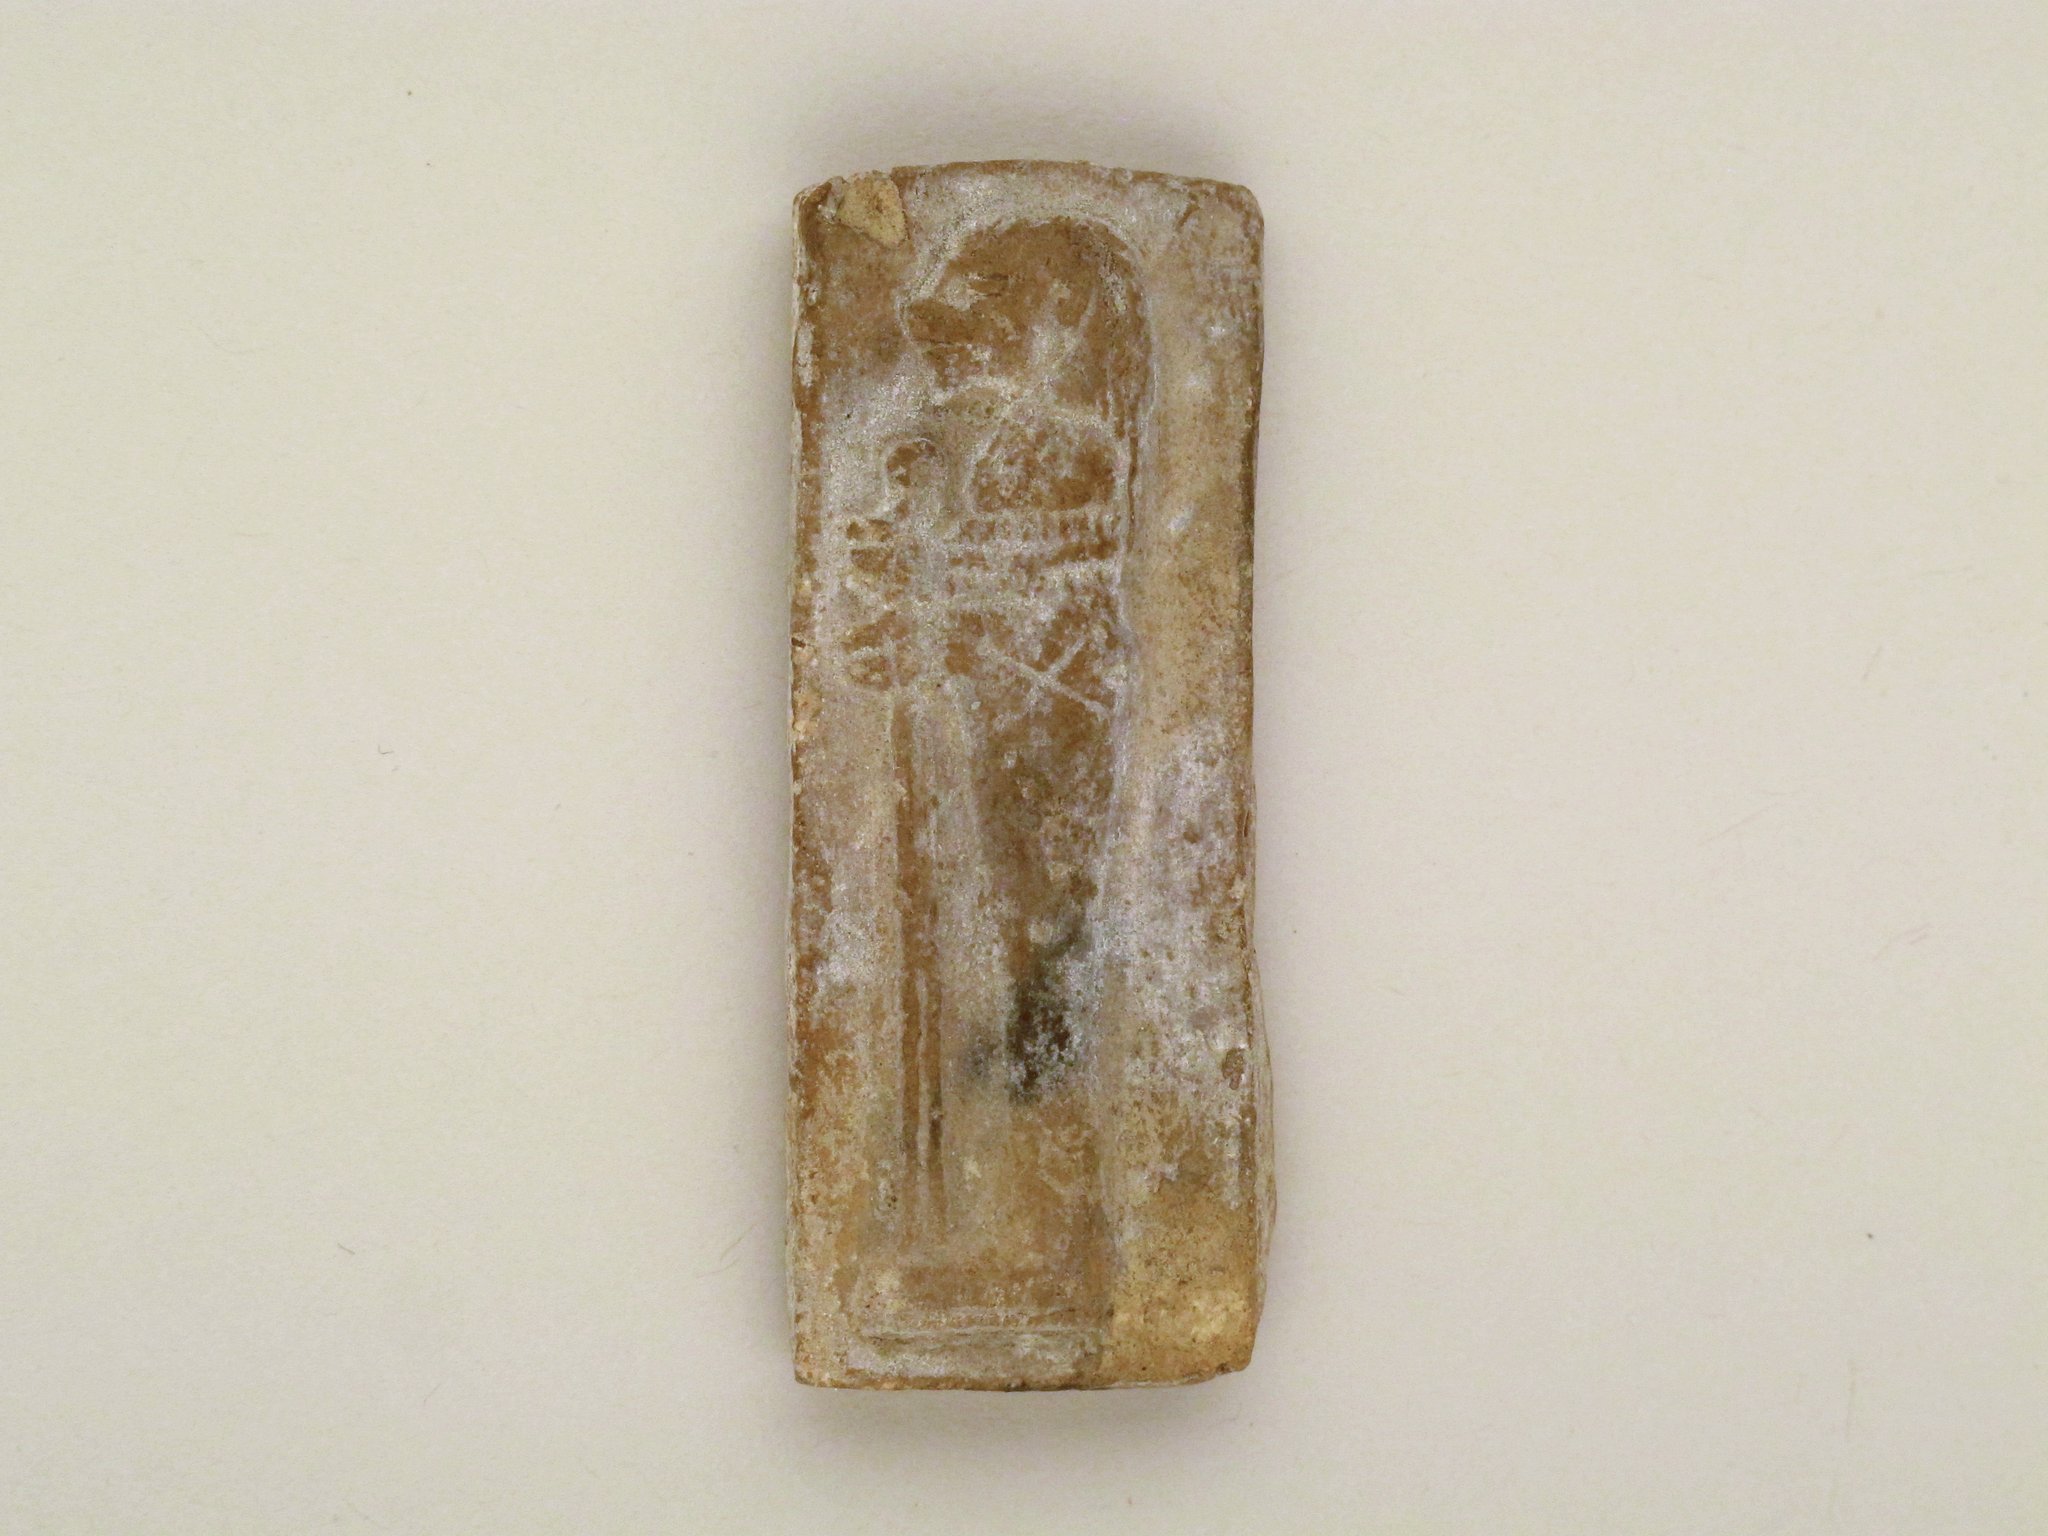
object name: plaque, unglazed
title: Terracotta mold for amulet of Osiris in mummyform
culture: egyptian or levantine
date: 664-630 BCE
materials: clay